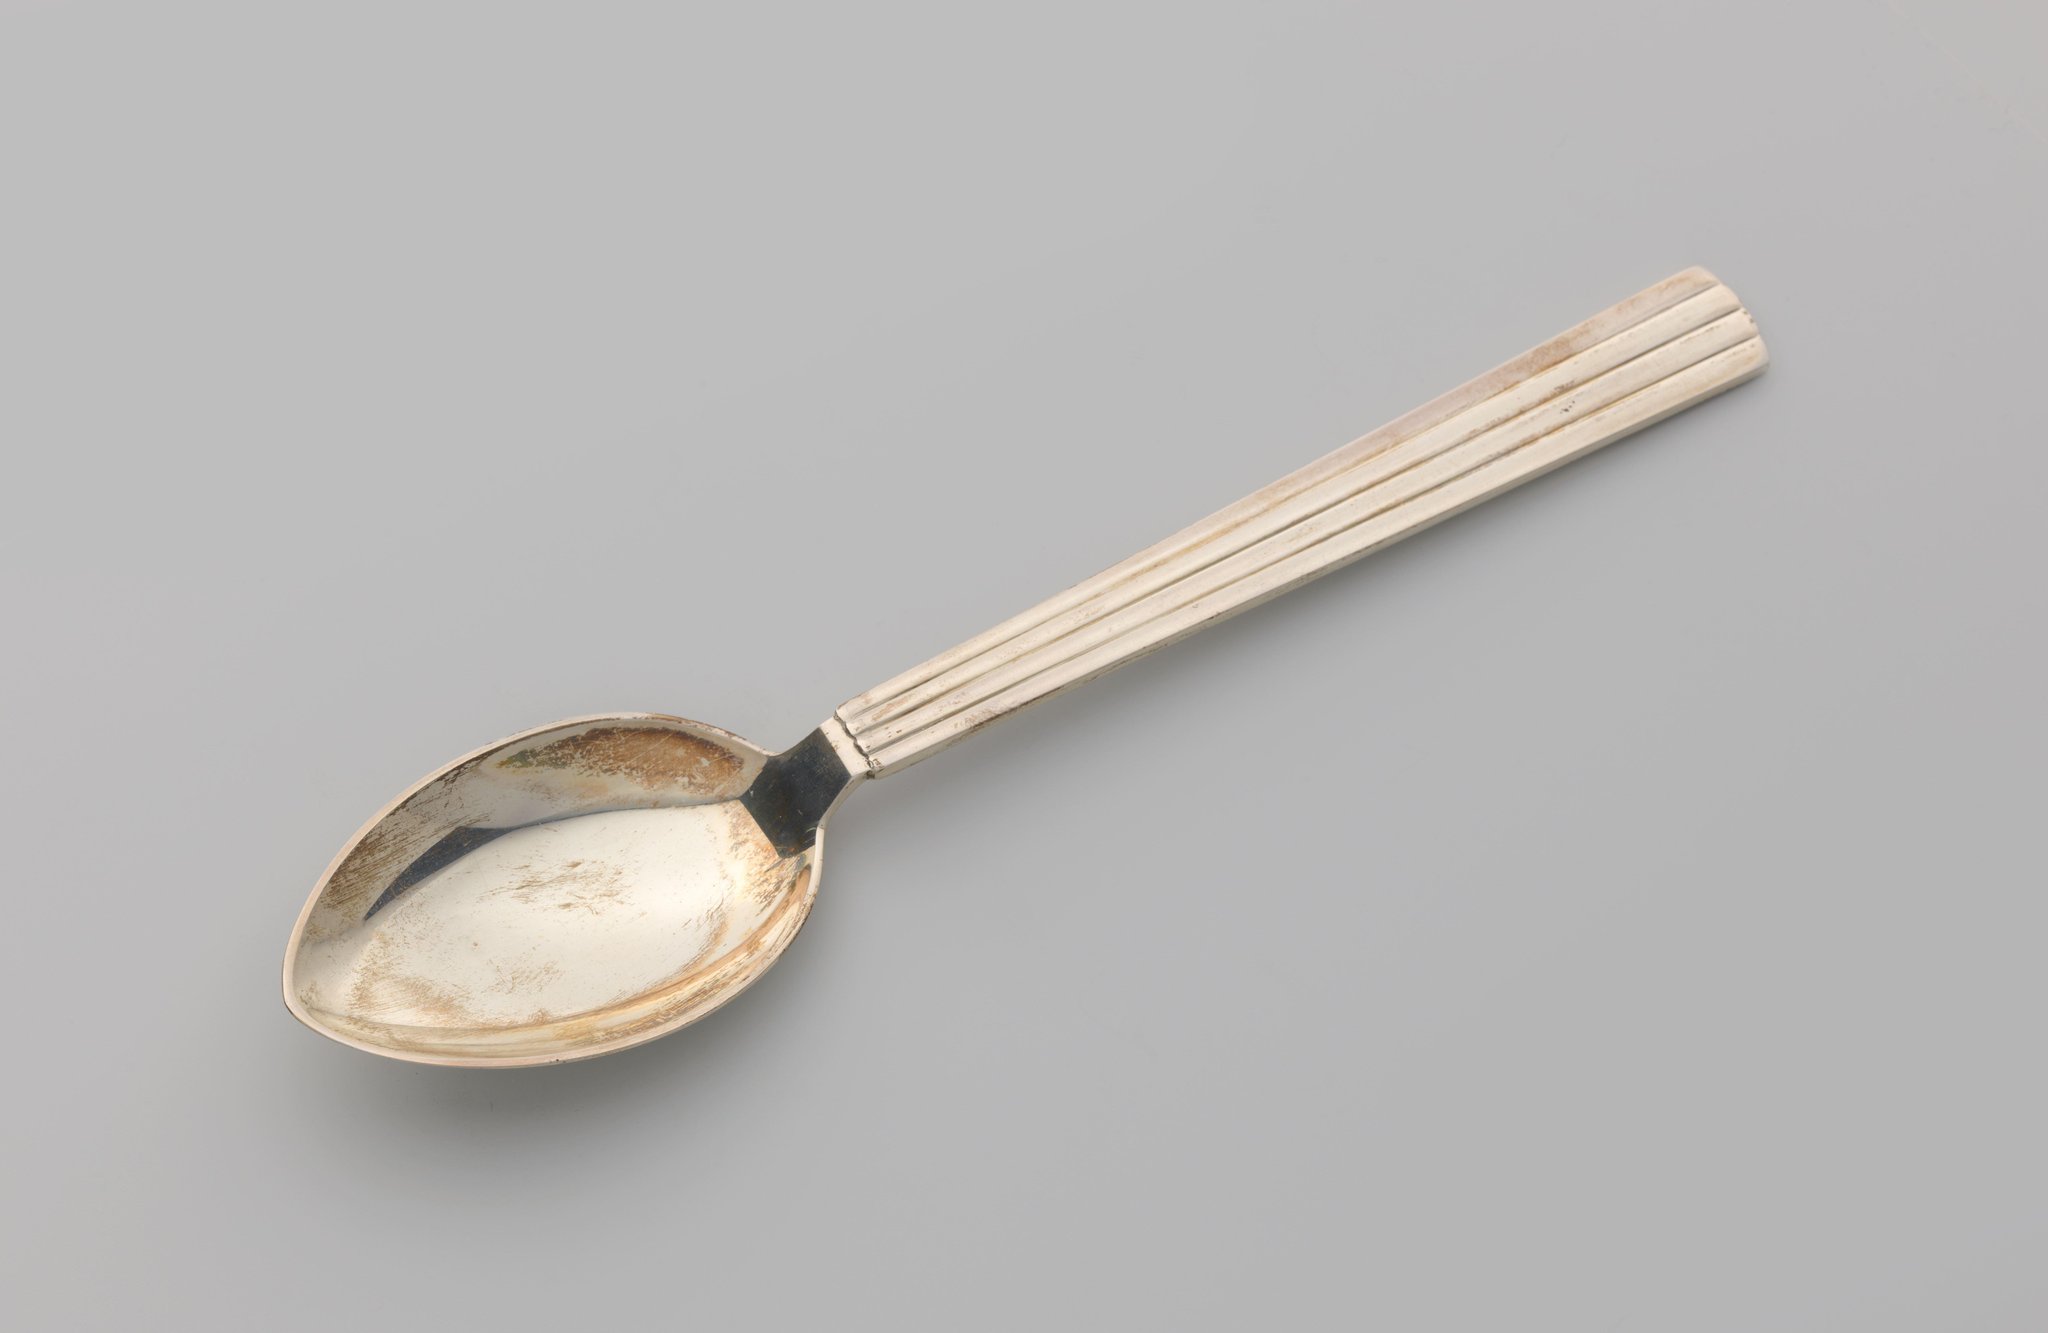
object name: spoon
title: Lepel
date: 1939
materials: silver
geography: copenhagen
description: Lepel van zilver met spits eivormige bak, model 'Bernadotte'. De platte, geribde steel verbreedt zich naar het uiteinde toe.